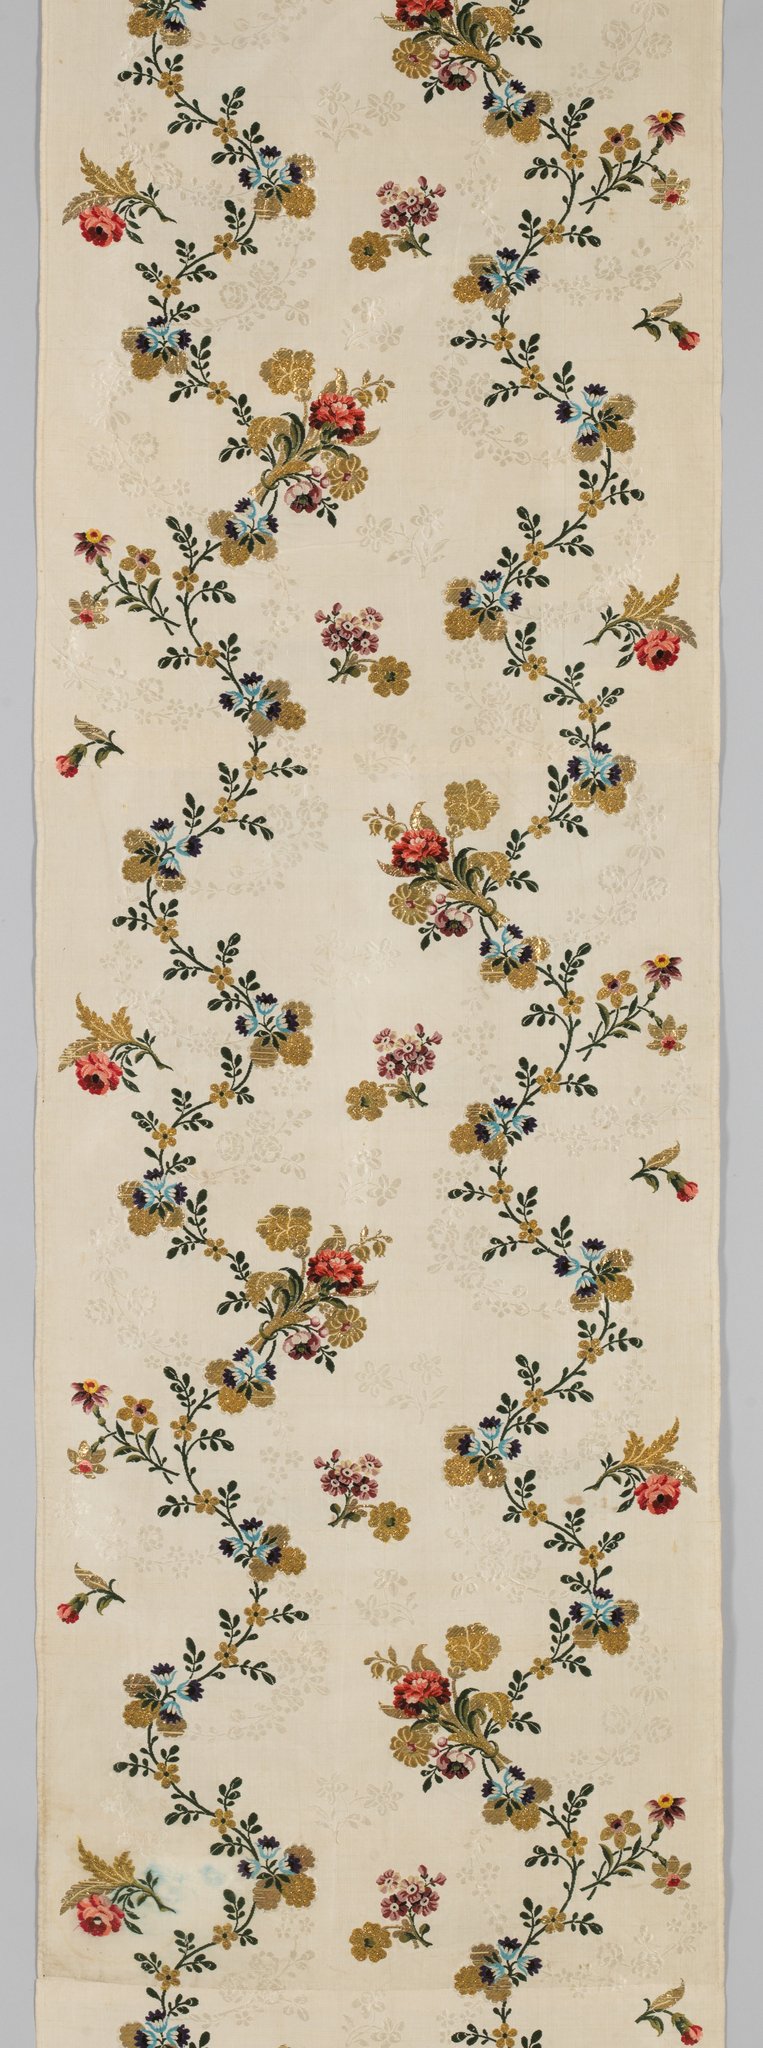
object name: piece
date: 1750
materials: metal thread, silk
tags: flowers,leaves